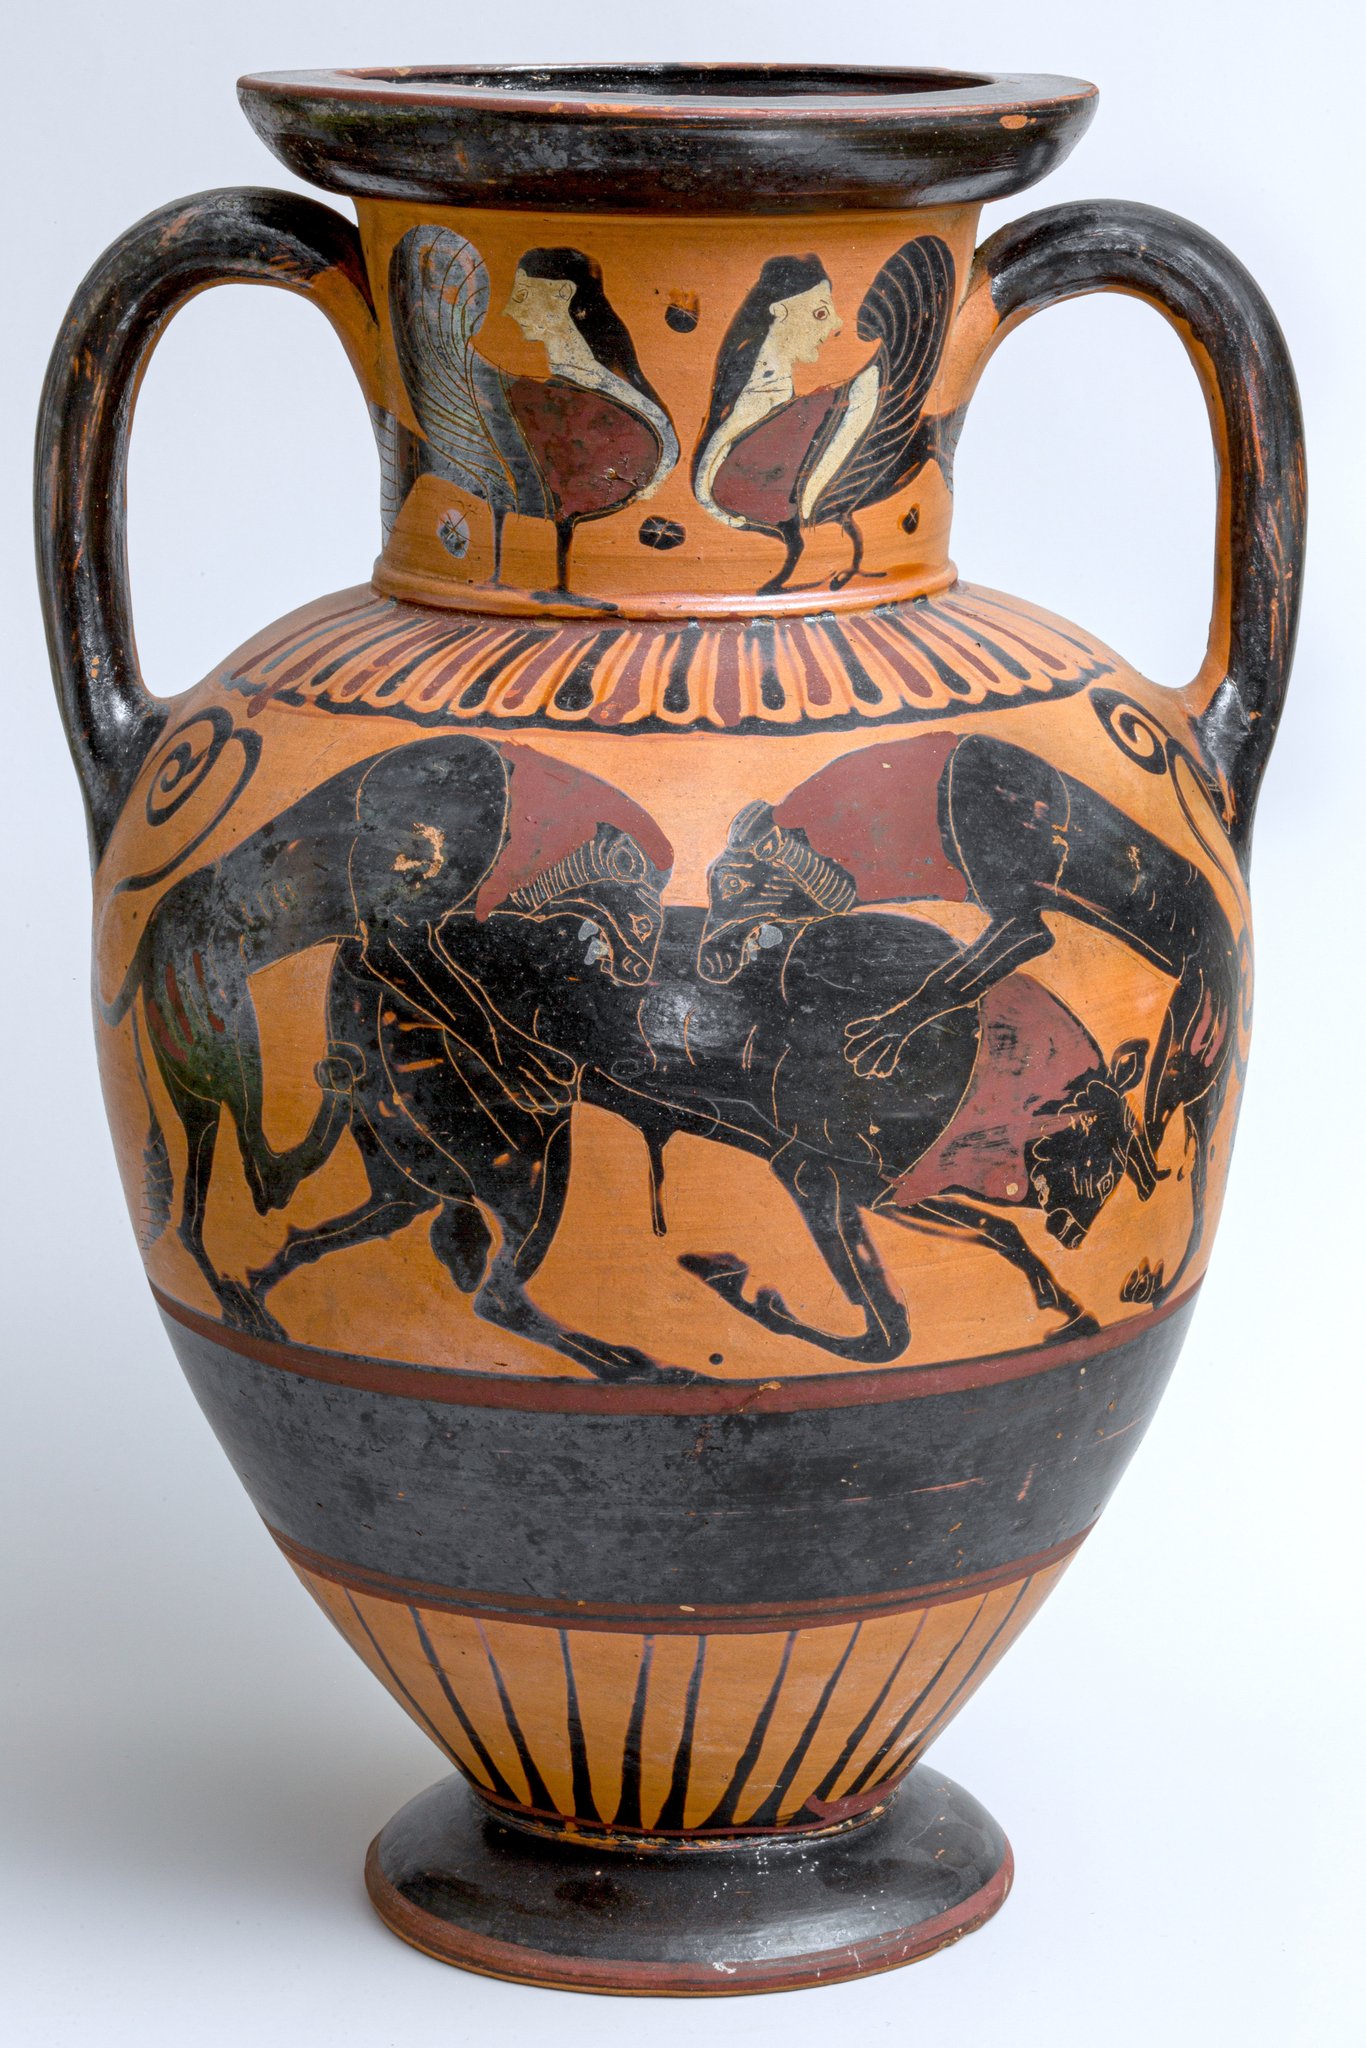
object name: neck amphora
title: Terracotta neck-amphora (jar)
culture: greek, chalcidian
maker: polyphemos group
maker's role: artist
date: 540-530 BCE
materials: terracotta